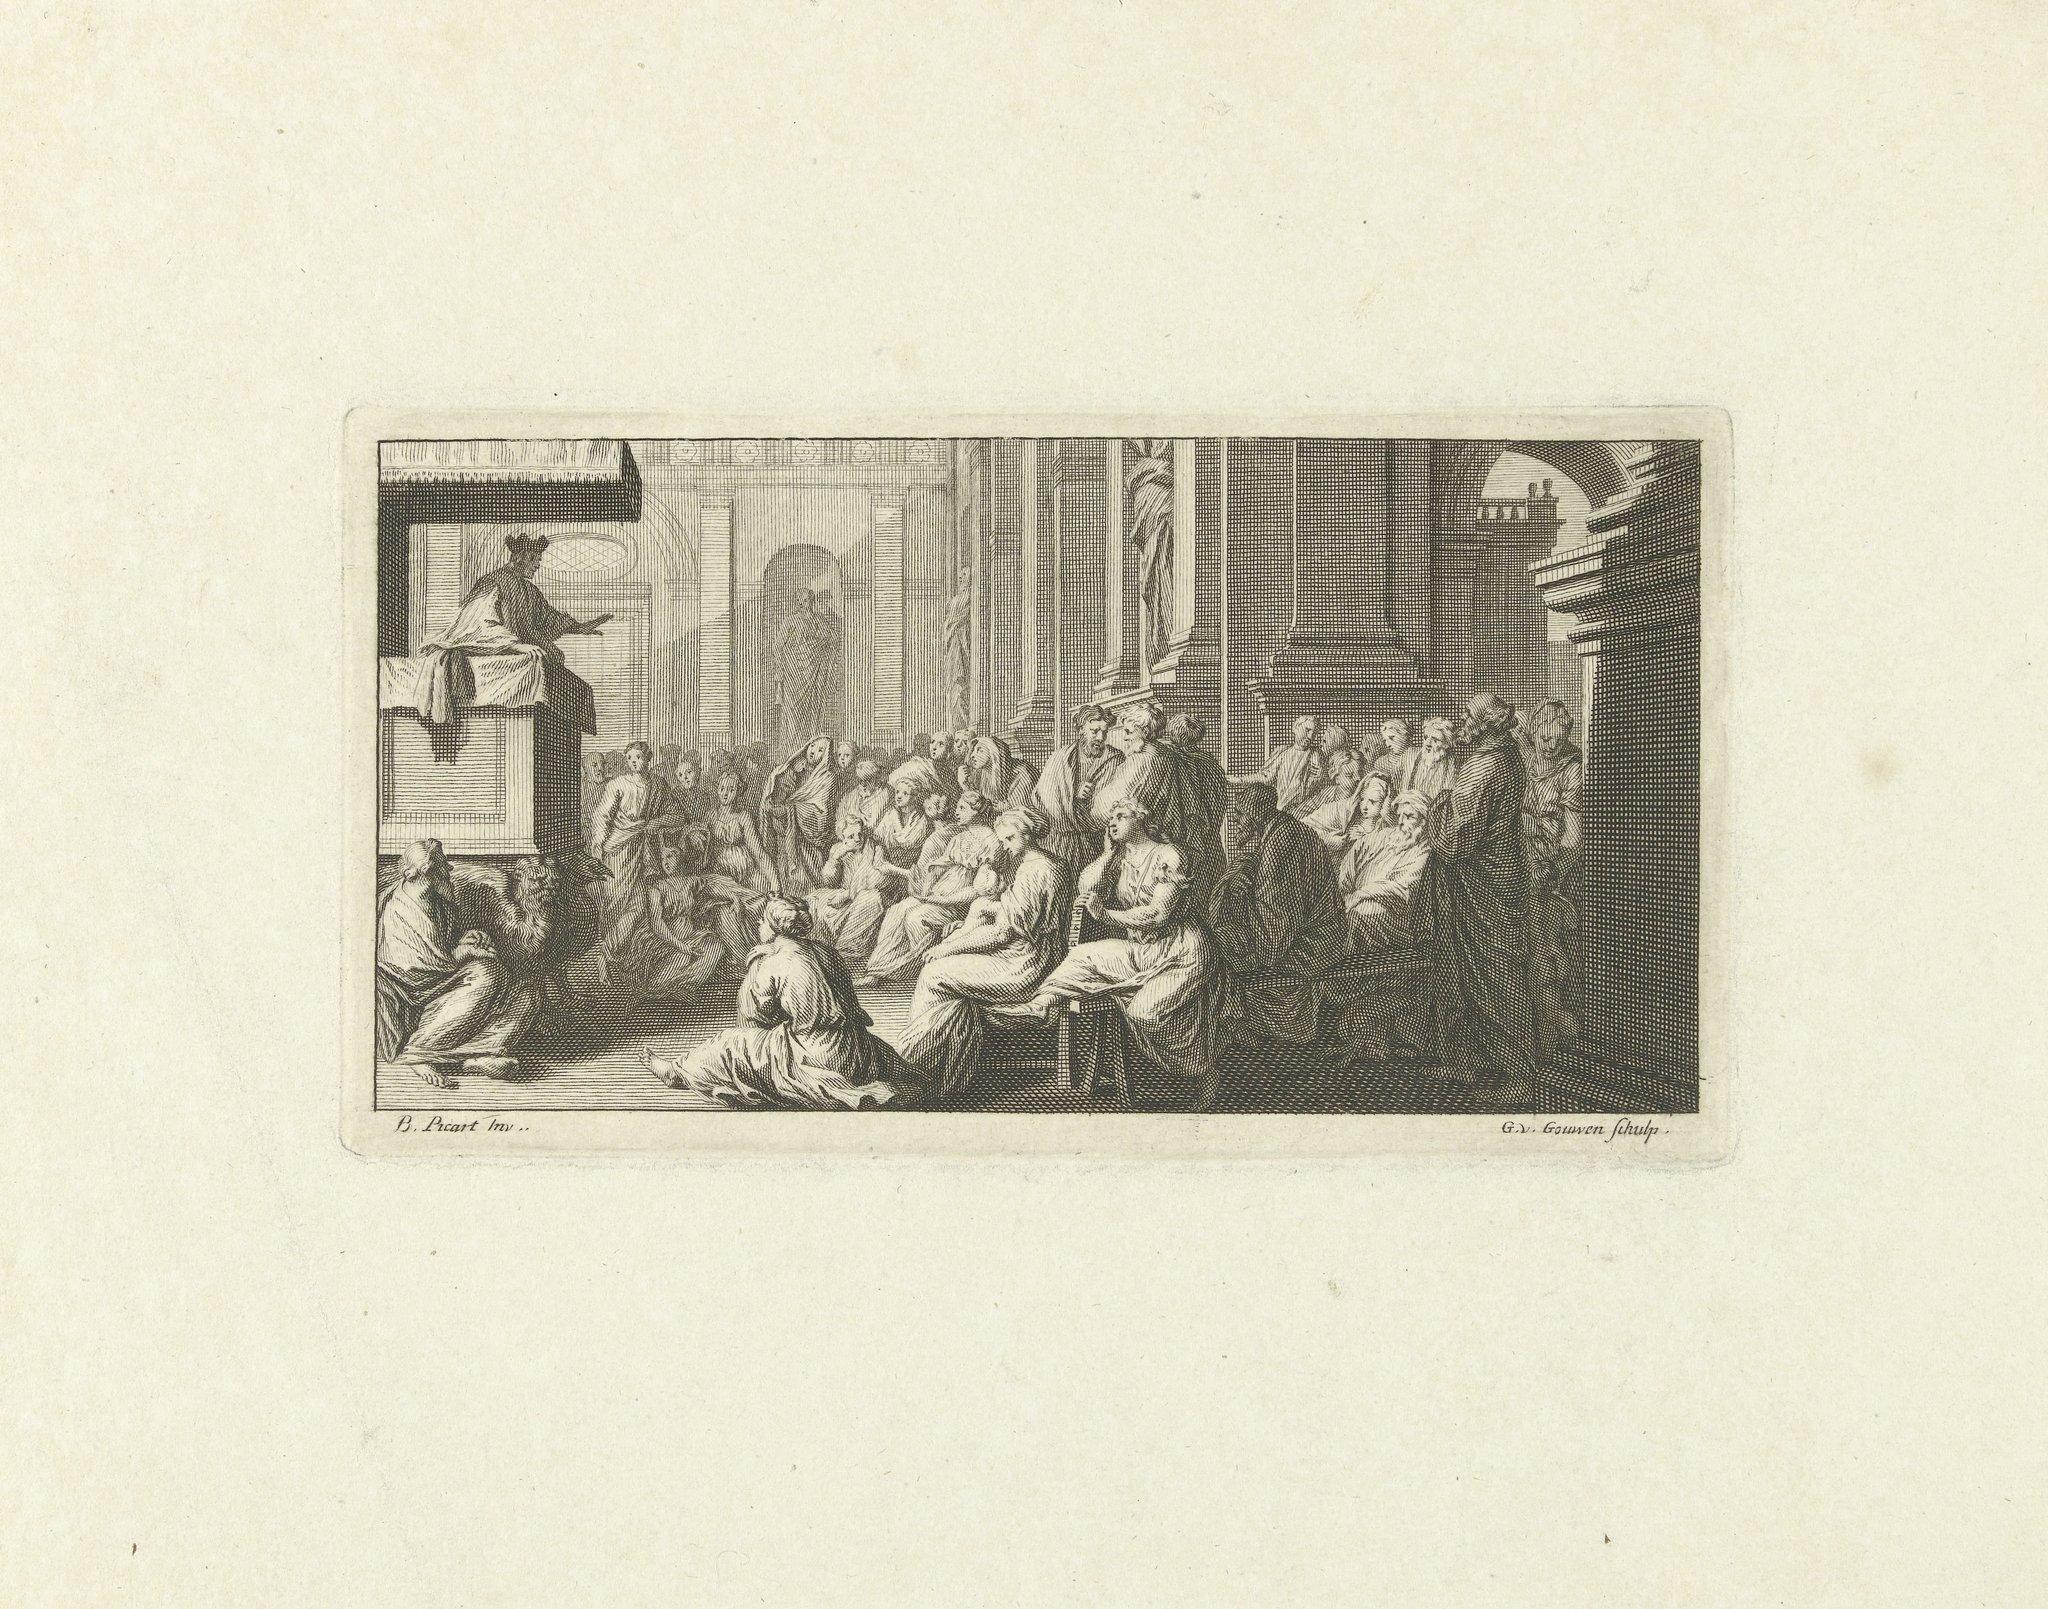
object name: print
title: Preek van een priester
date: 1670-1740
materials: paper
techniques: engraving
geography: amsterdam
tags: priest (roman catholic), roman catholic church, preaching (in general)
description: In een kerk staat een priester op een preekstoel en preekt voor een menigte van vrouwen en mannen.